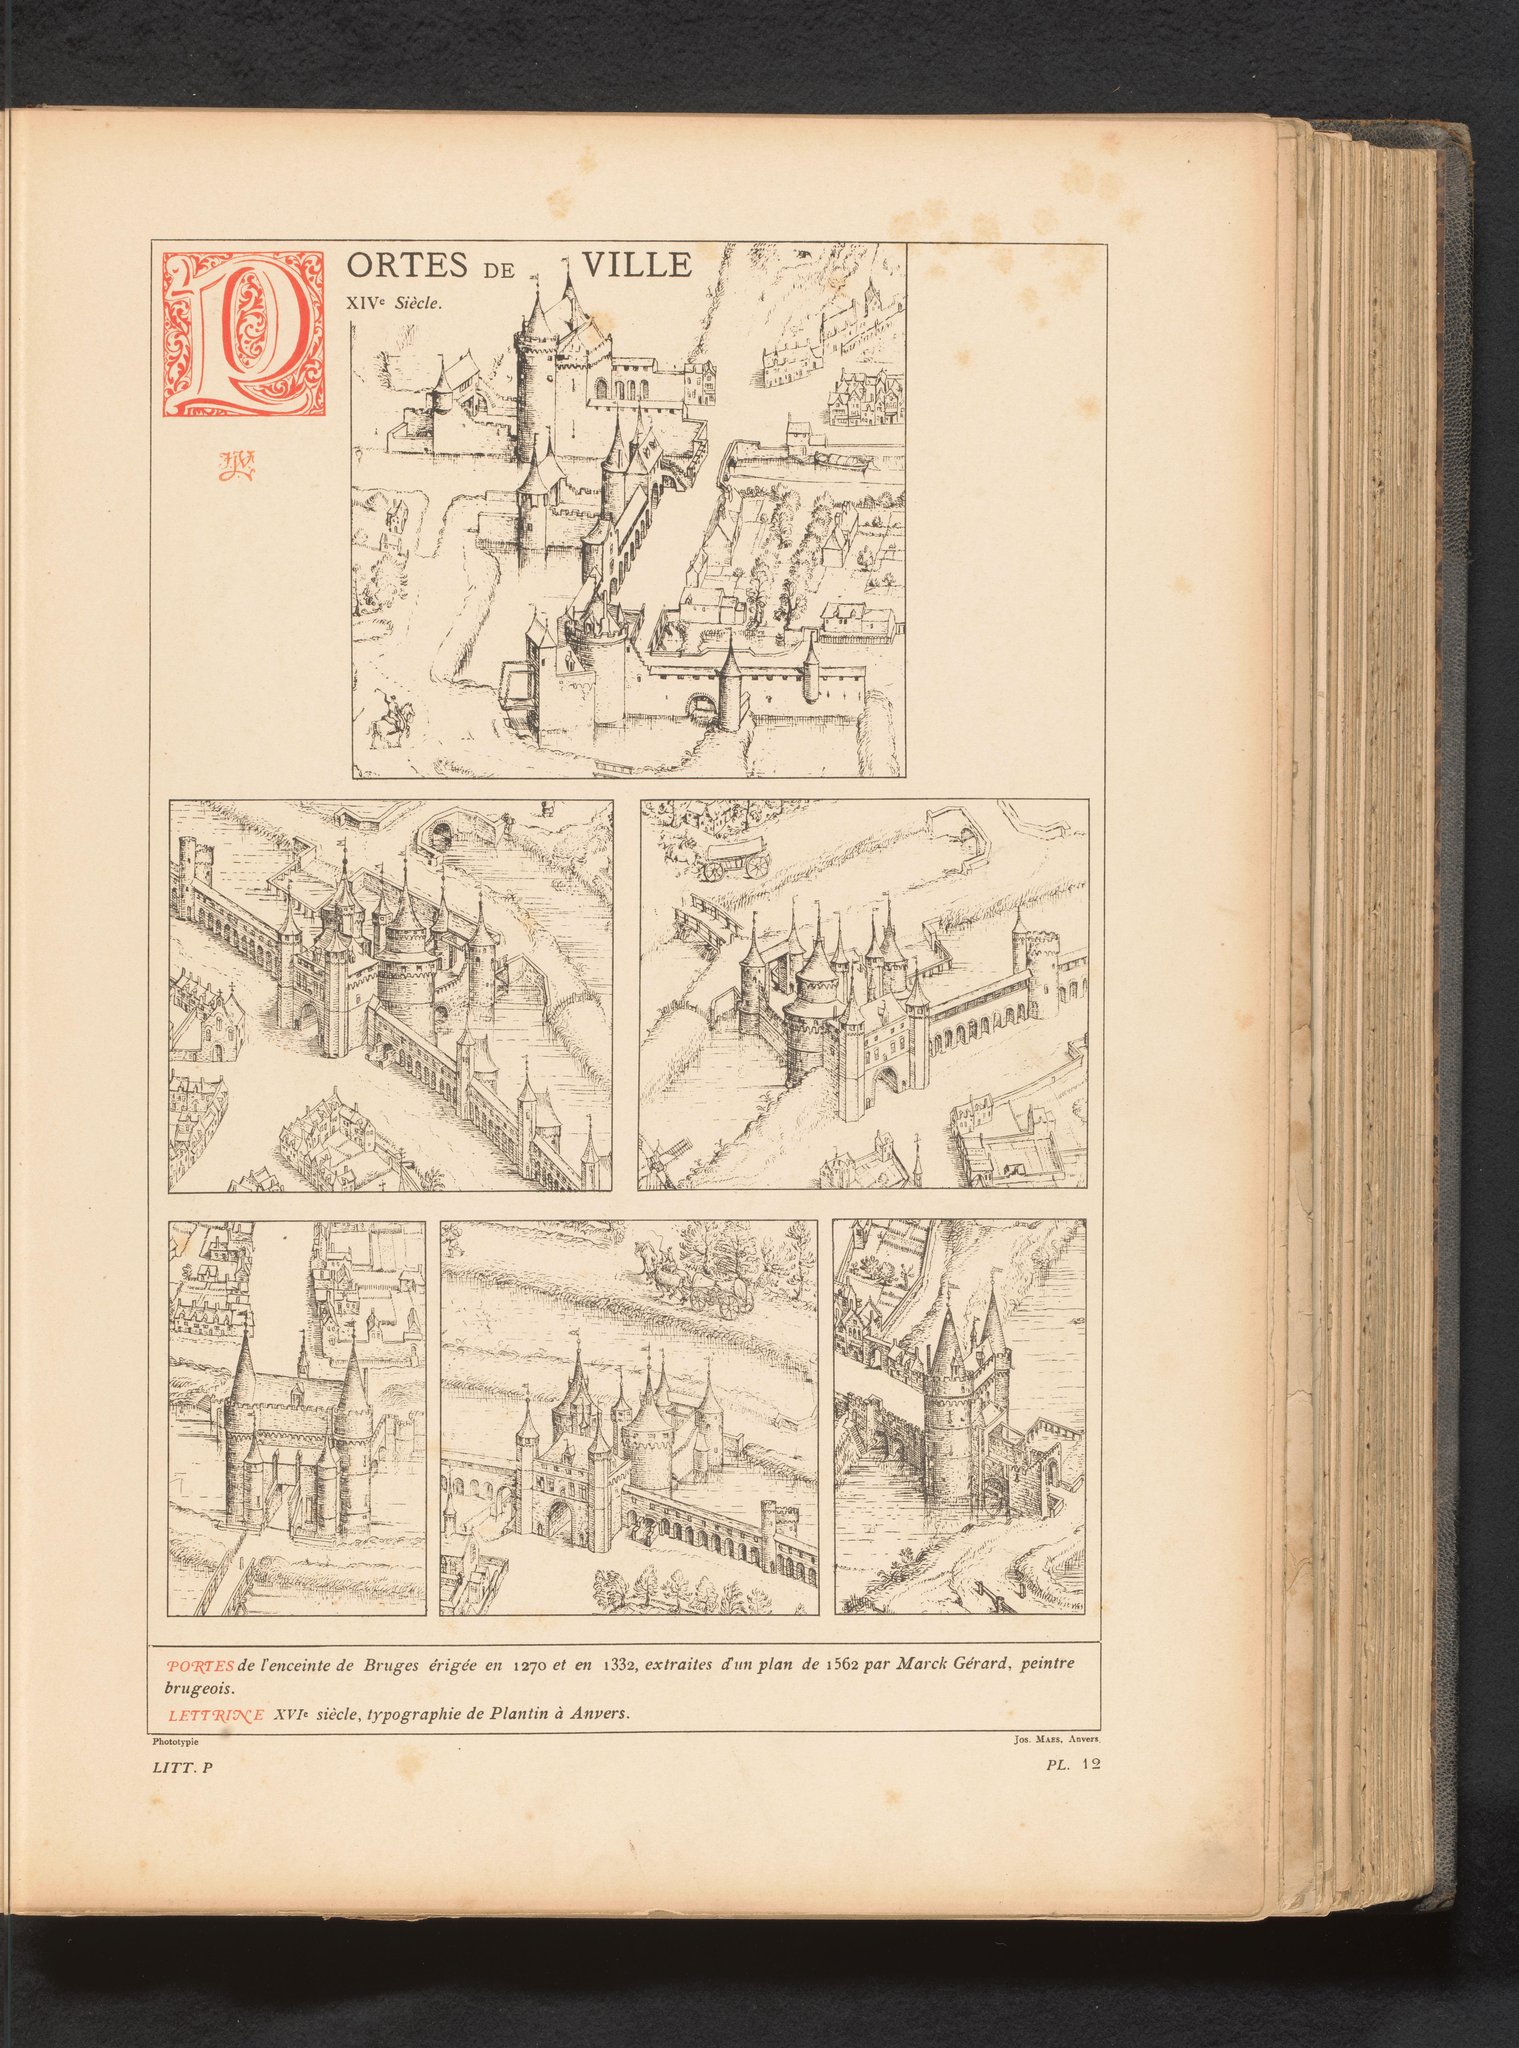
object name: page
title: Portes de Ville, XIVe Siècle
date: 1876-1881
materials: paper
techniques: photolithography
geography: amsterdam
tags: village-gate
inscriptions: monogram: ‘JJvY’, inscription: ‘LITT. P. - PL. 12.’, inscription: ‘PORTES de l'enceinte (...)’